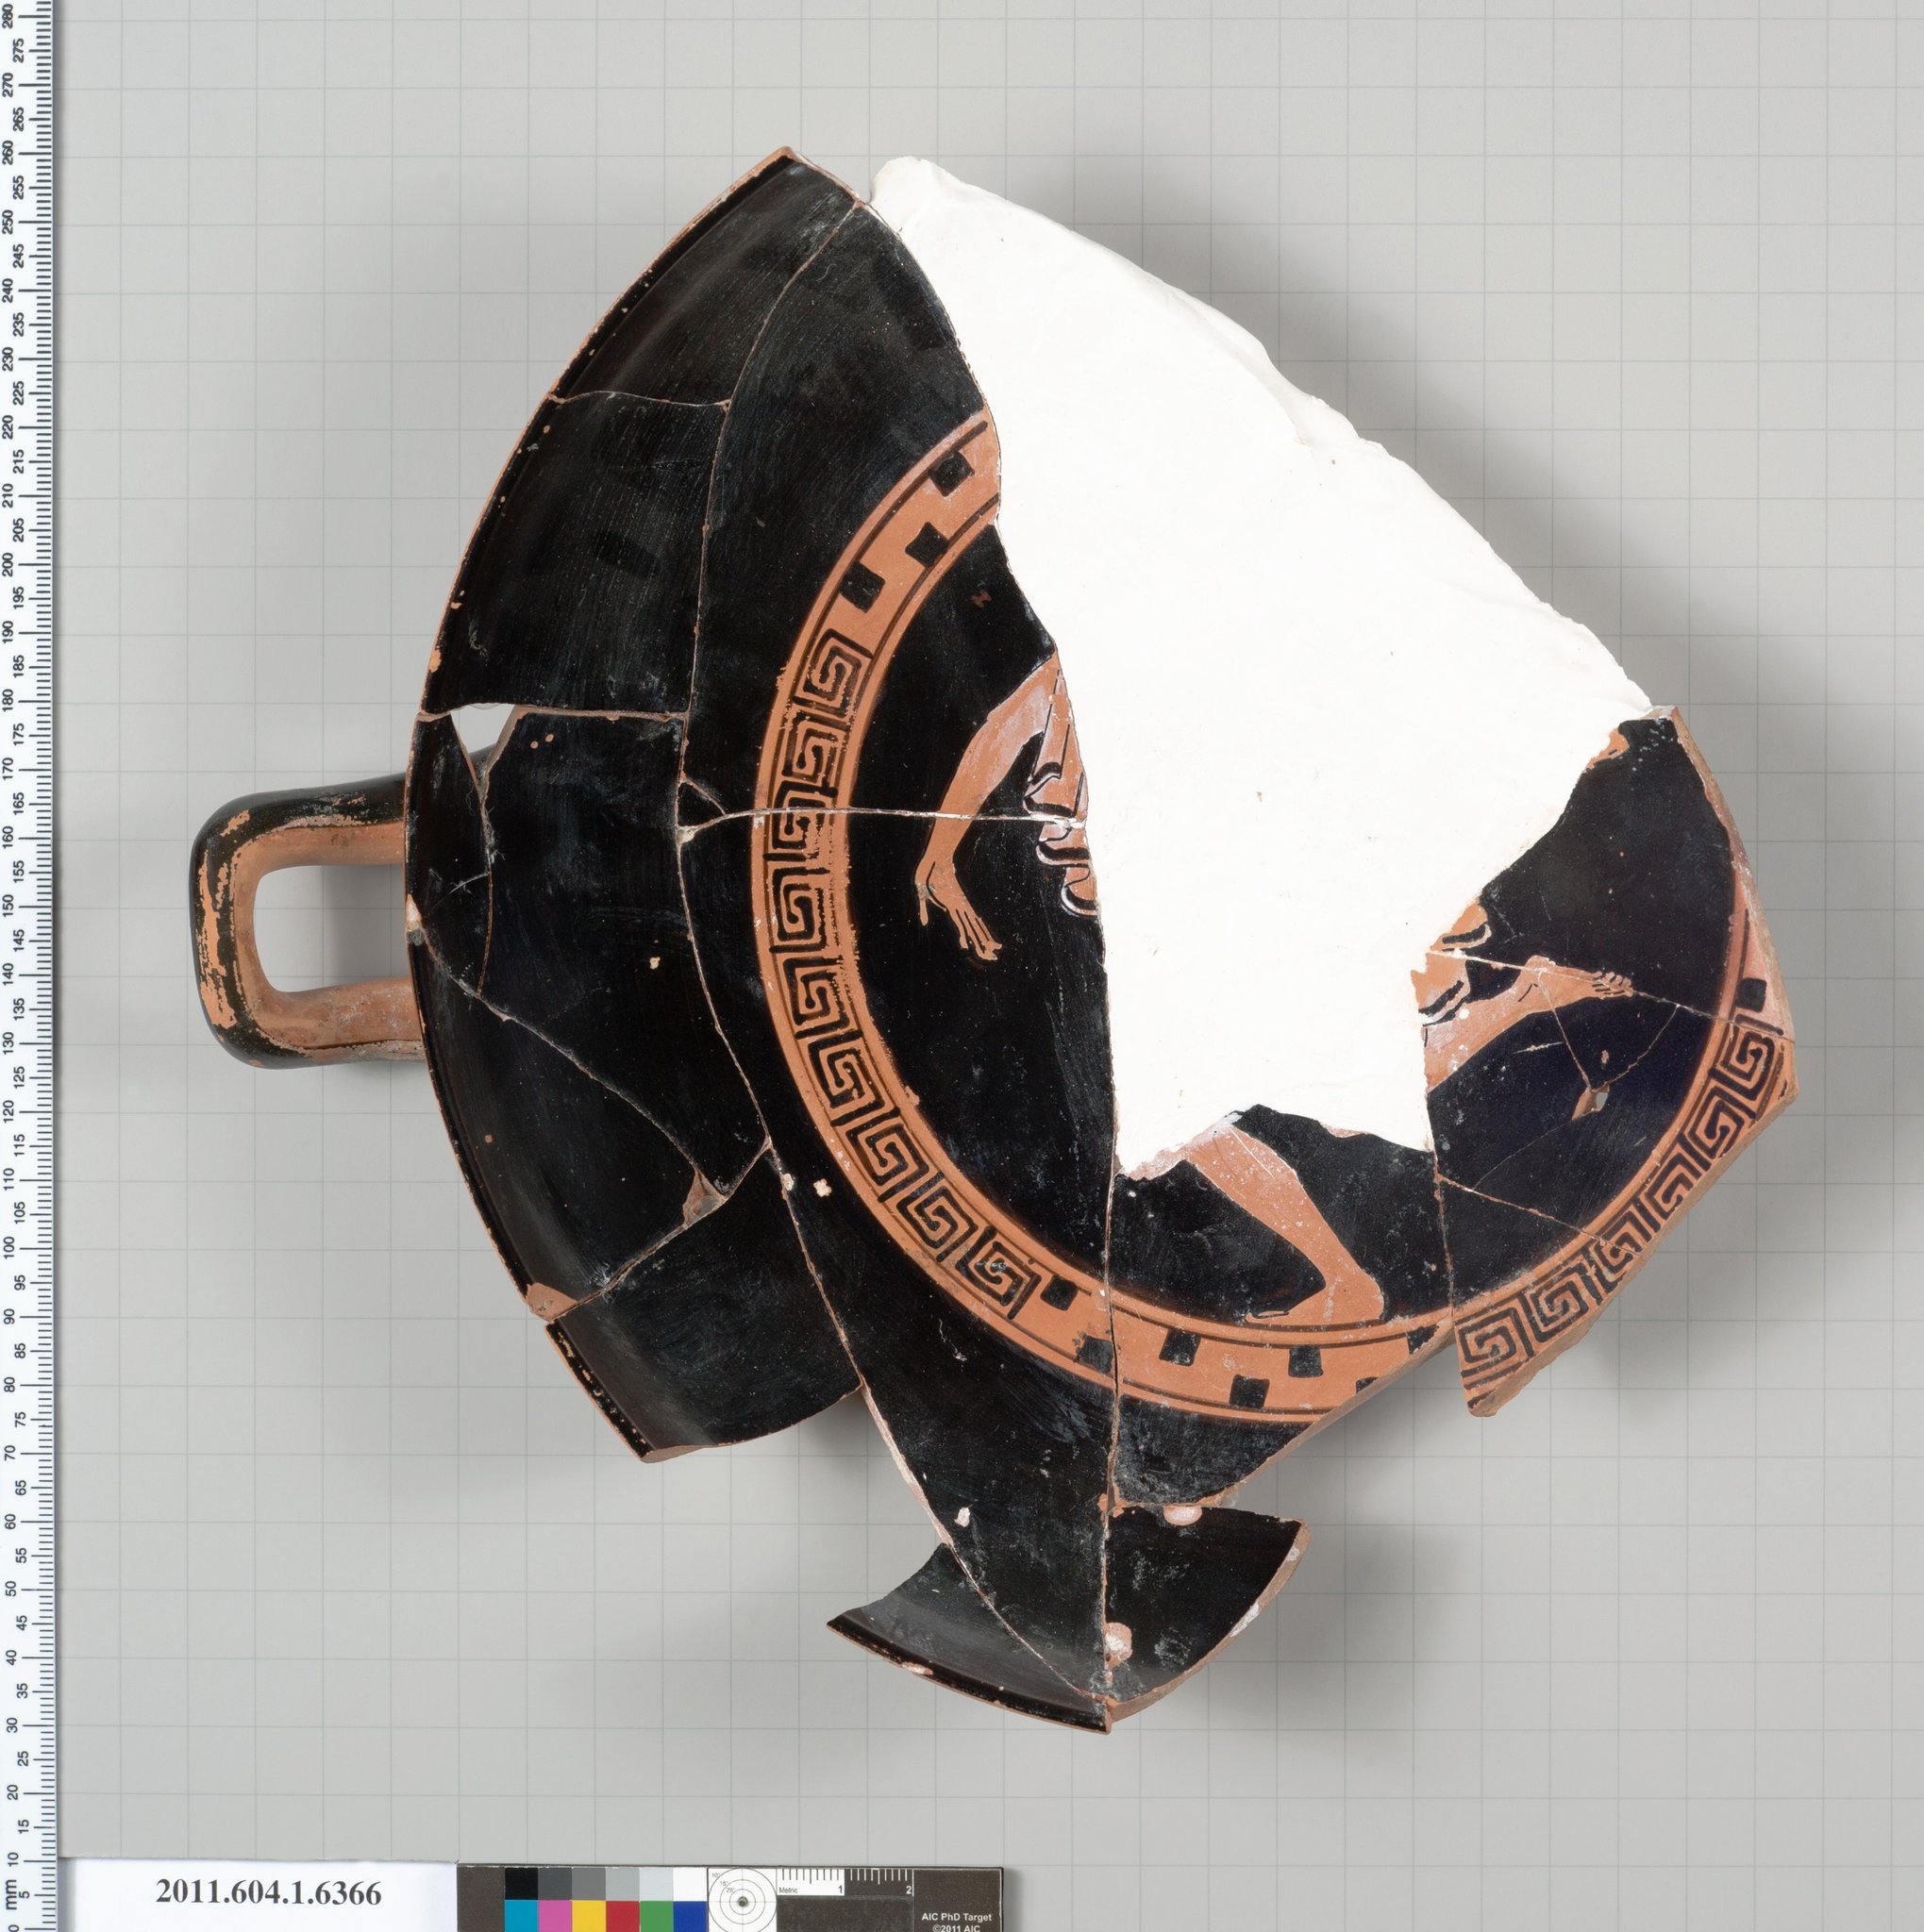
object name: kylix fragment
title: Terracotta fragment of a kylix (drinking cup)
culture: greek, attic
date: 490-480 BCE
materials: terracotta